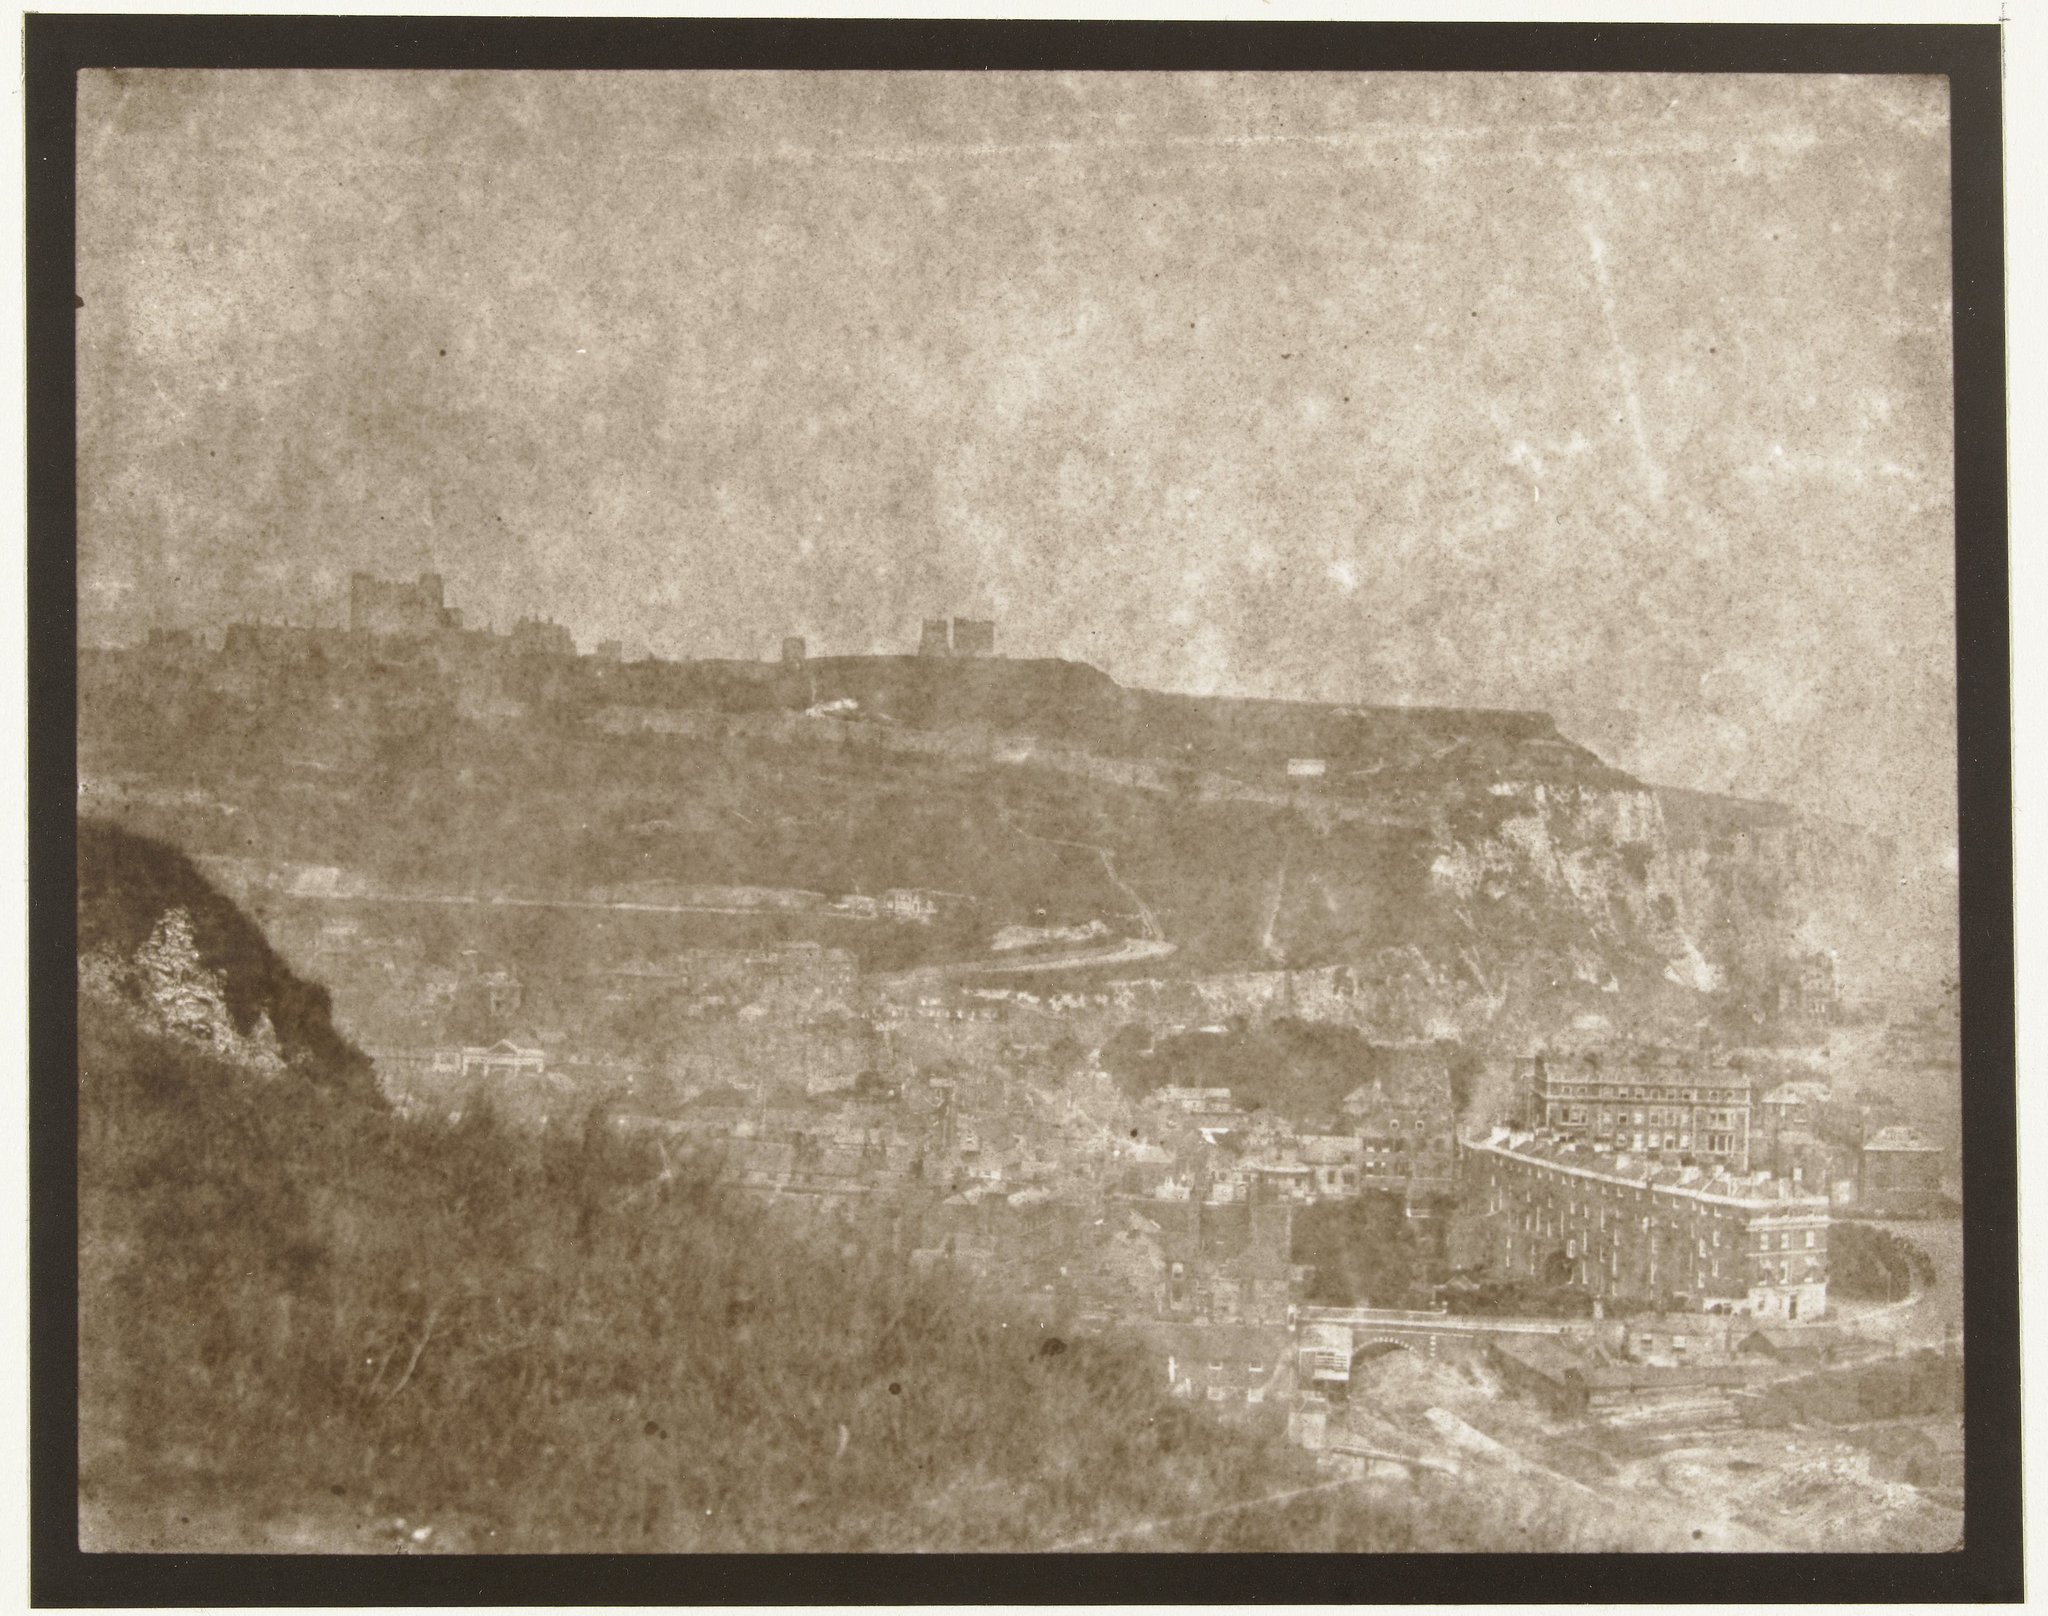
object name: photograph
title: Gezicht op Dover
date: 1927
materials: paper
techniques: gelatin silver print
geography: france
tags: city-view in general; 'veduta'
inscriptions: watermark: ‘Arches/ France’